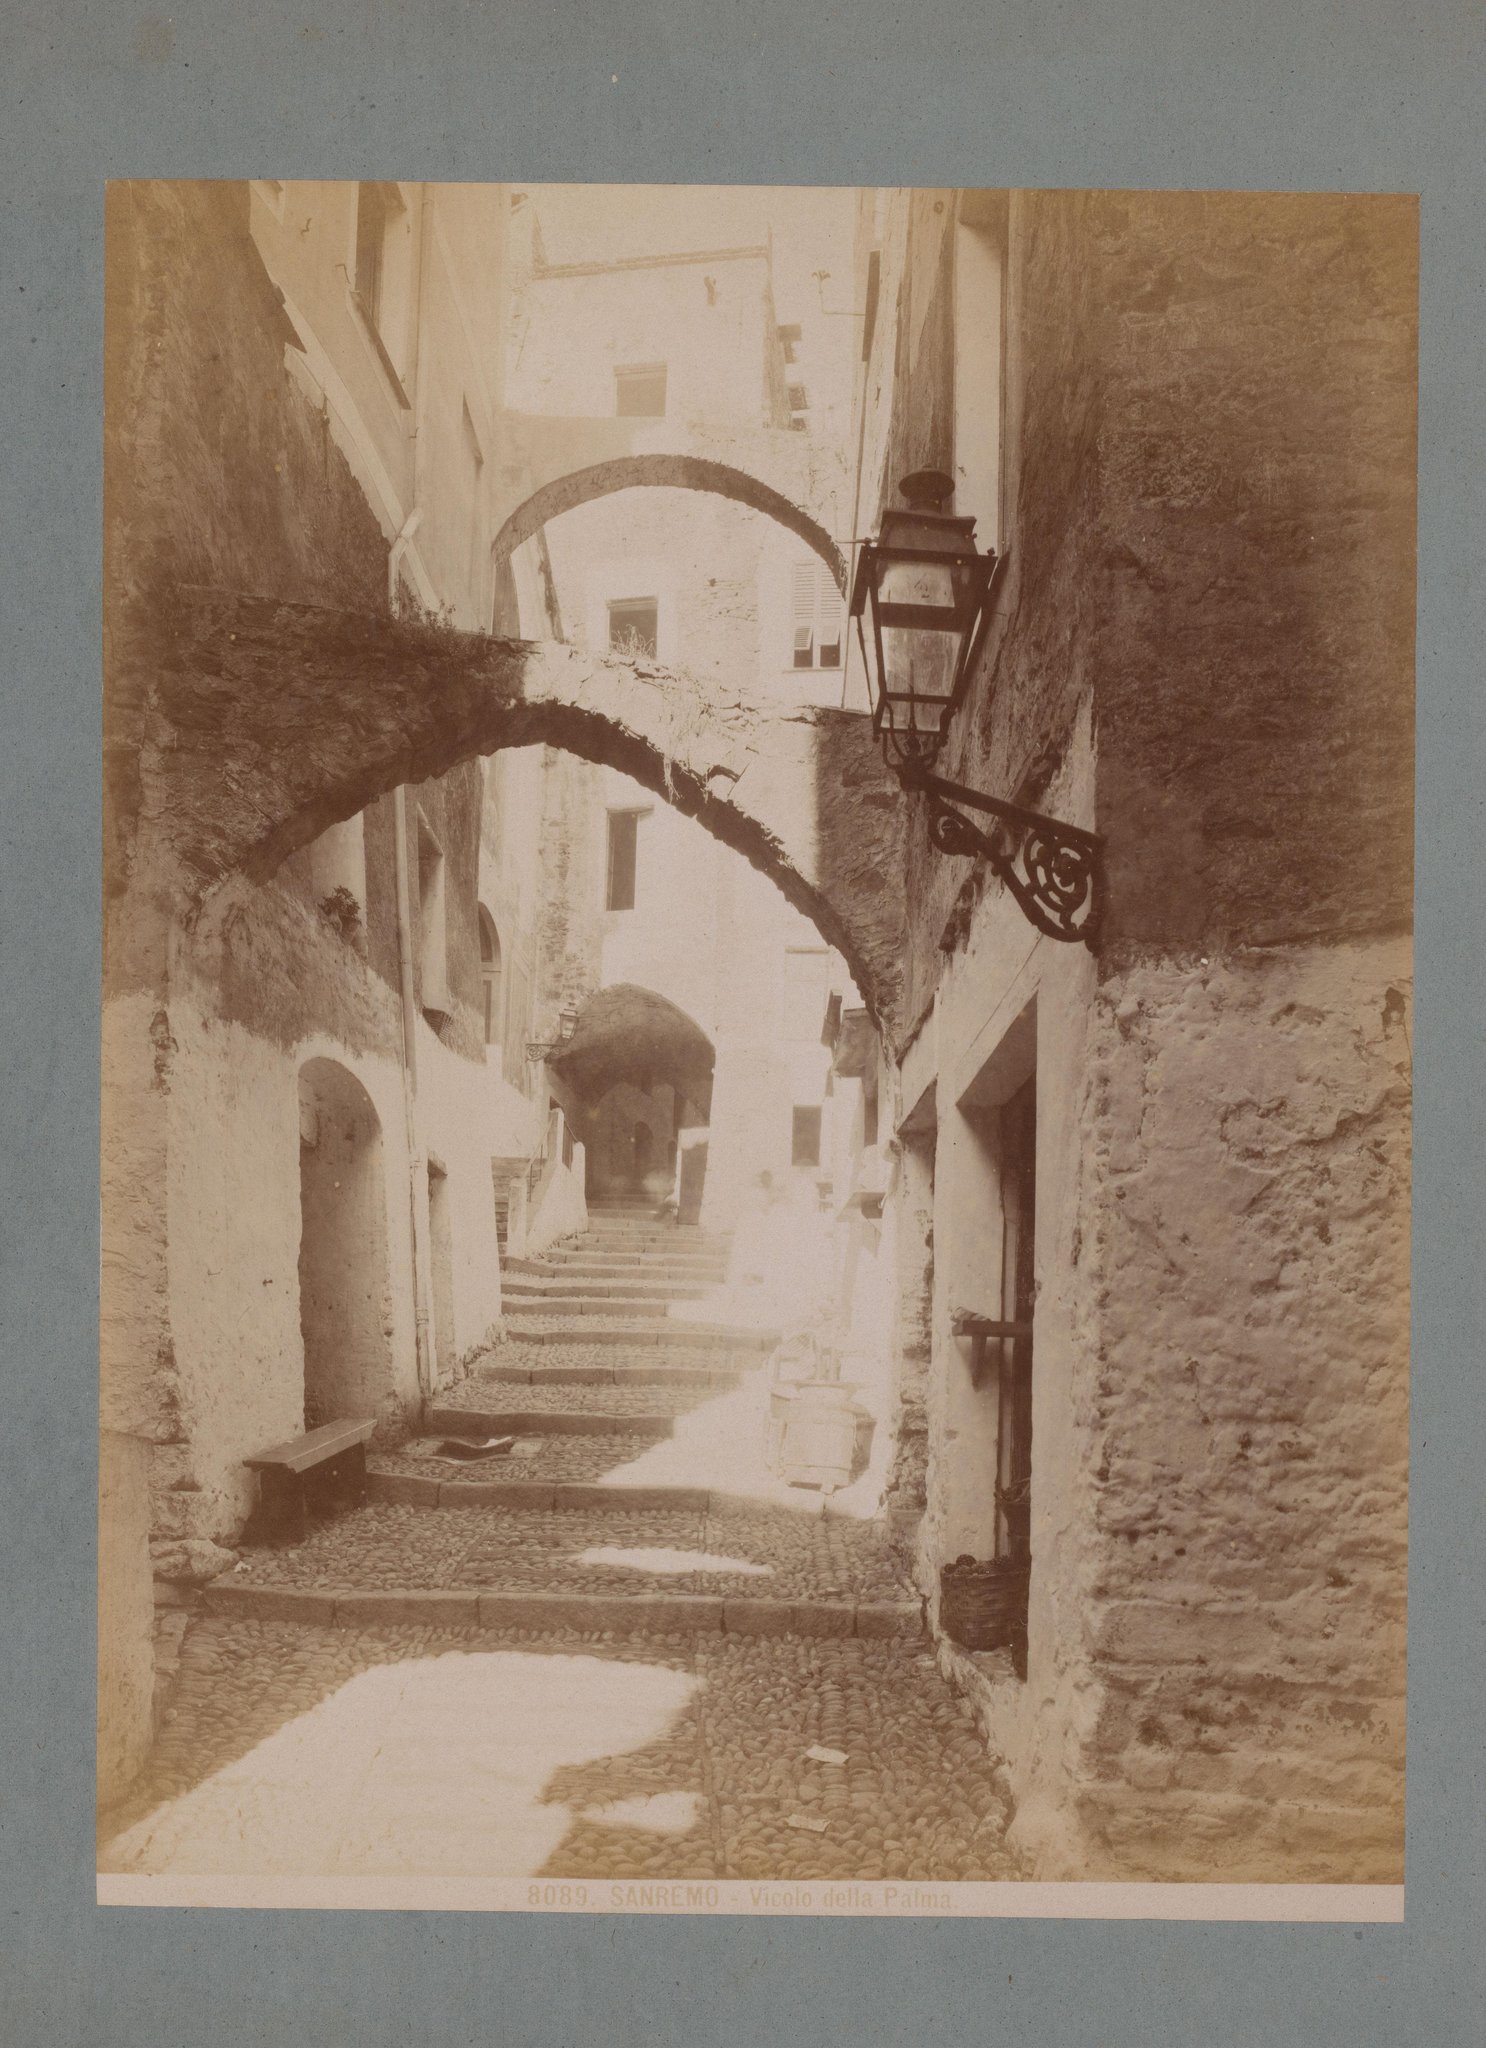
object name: photograph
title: Zicht in de Vicolo della Palma te San Remo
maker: giacomo brogi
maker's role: fotograaf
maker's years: 1822-1881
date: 1864-1881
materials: cardboard, paper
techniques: albumen print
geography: san remo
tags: sloping street; street with steps or stairs, public road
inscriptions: number: ‘8089.’, collector's mark: ‘VOSMAER’